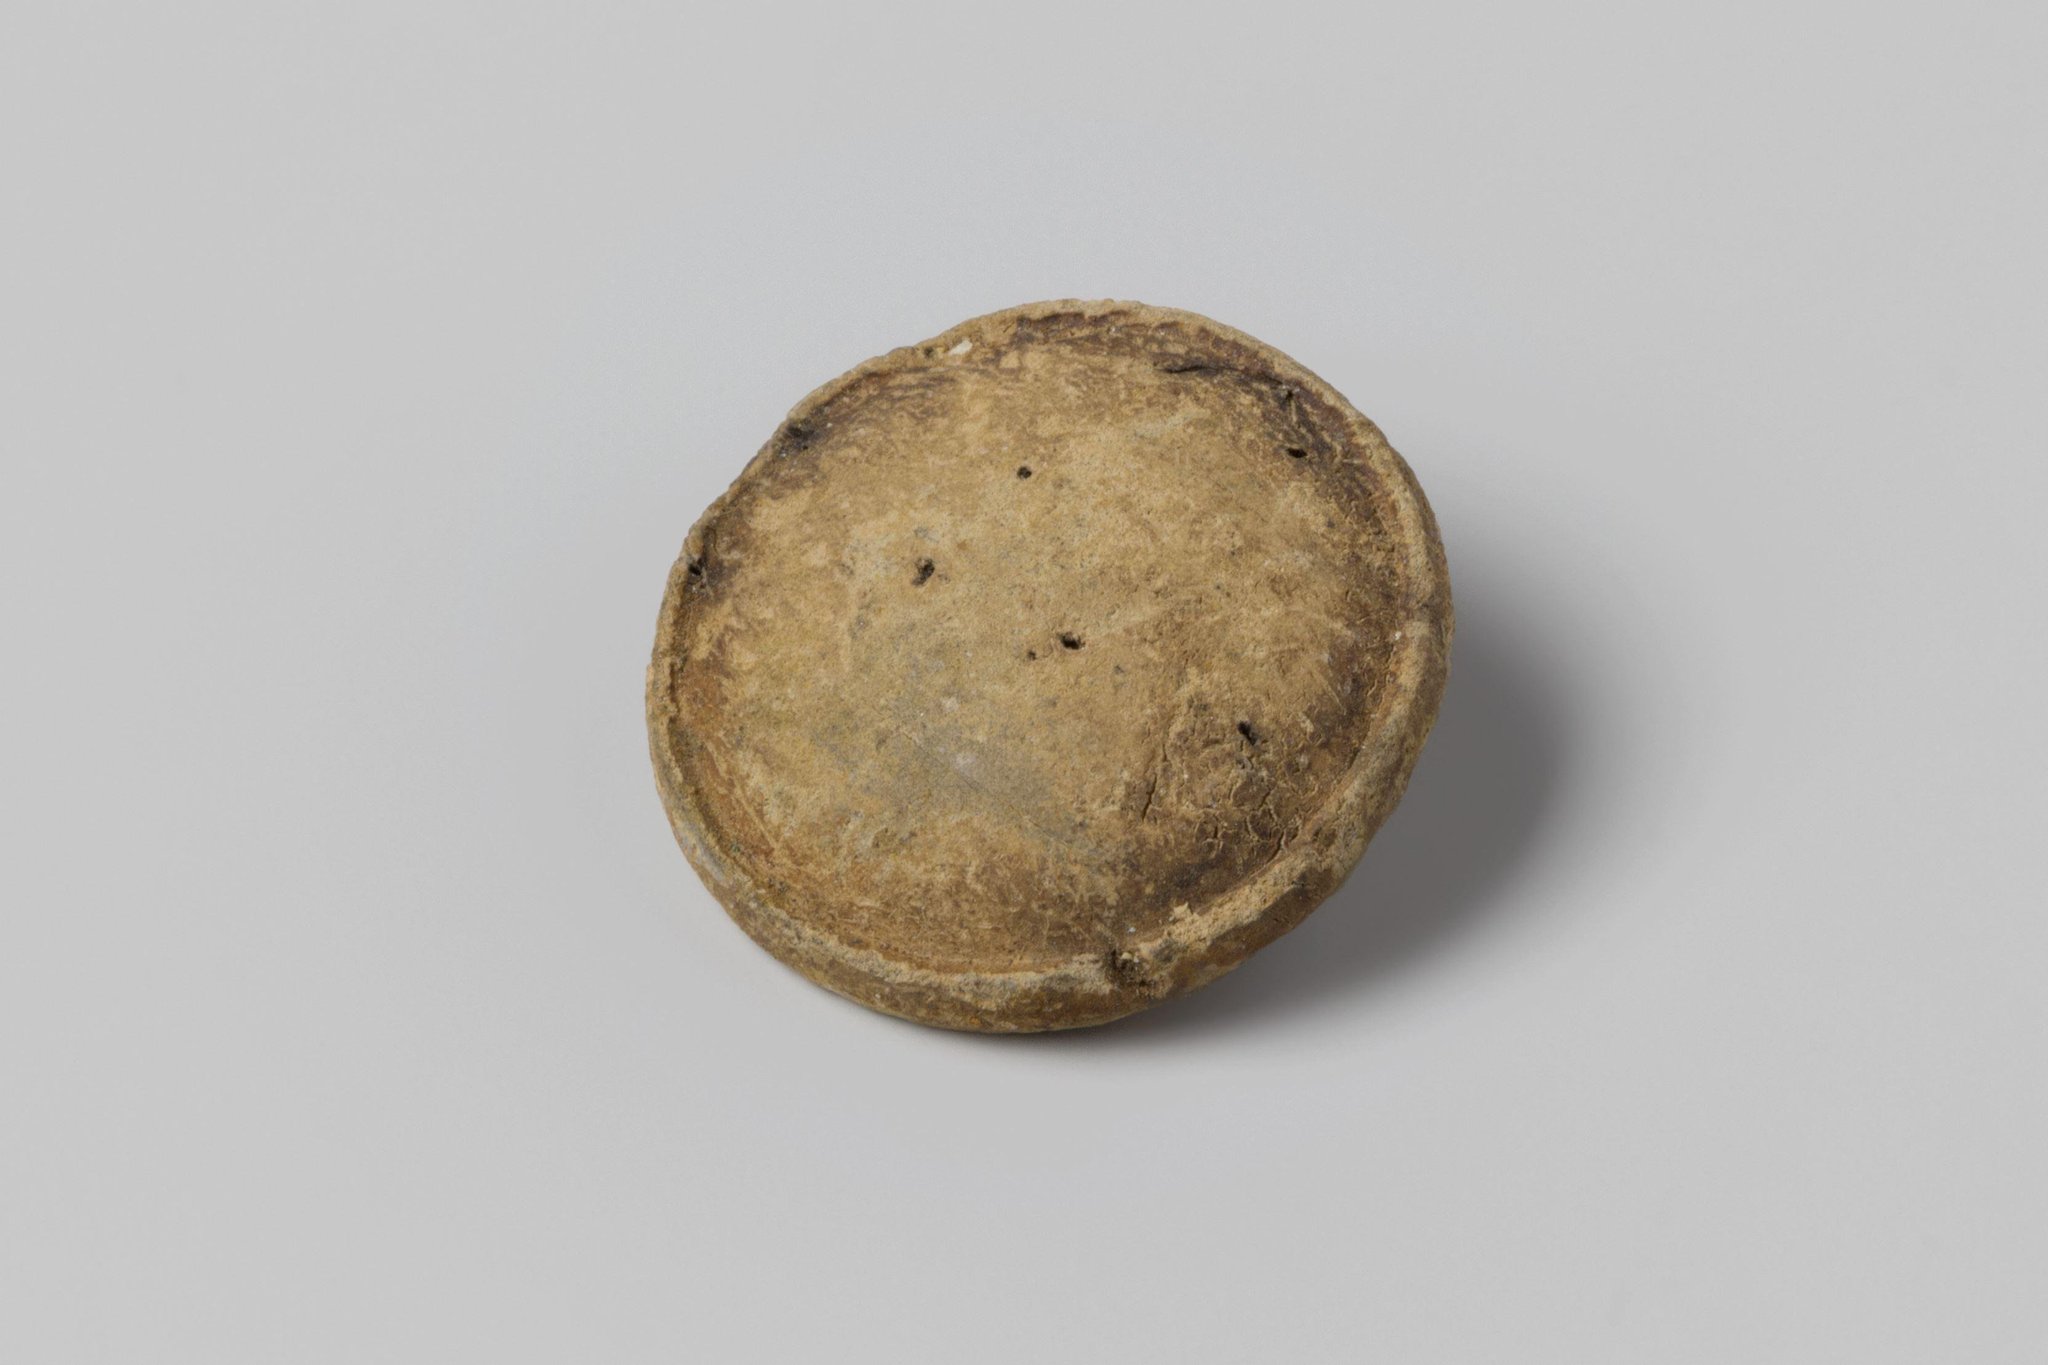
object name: button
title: Knoop uit het wrak van de Oost-Indiëvaarder Hollandia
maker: Anonymous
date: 1700-1743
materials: bone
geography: netherlands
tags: verenigde oostindische compagnie, hollandia (schip), annet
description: Knoop. (1) sim. NG 1980-27H1185 (1.9d, 0.5h)